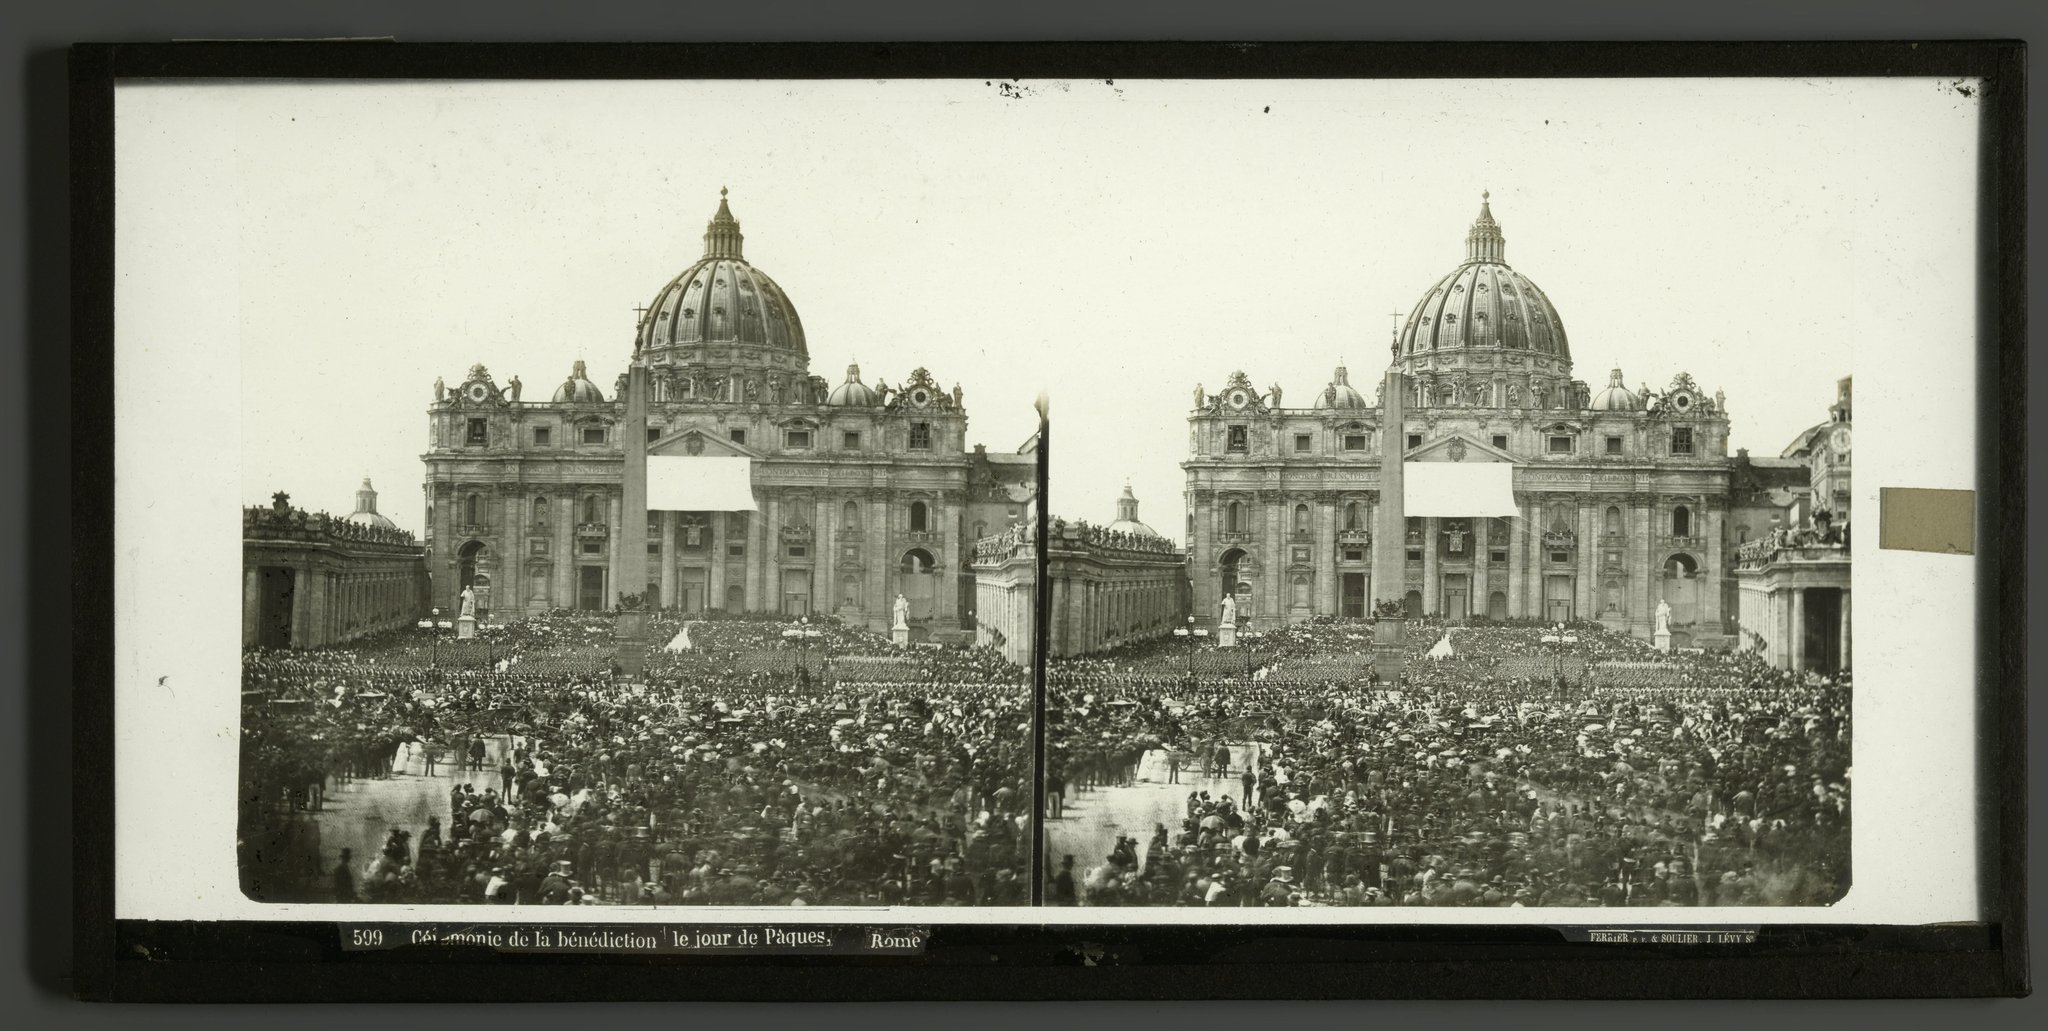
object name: stereoscopic photograph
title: Gezicht op de Sint-Pietersbasiliek tijdens de viering van het Paasfeest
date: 1860-1870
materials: glass, paper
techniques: slide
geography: rome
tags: square, place, circus, etc., church (exterior)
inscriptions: inscription: ‘599. Ceremonie de la benediction le jour de Paques, Rome’